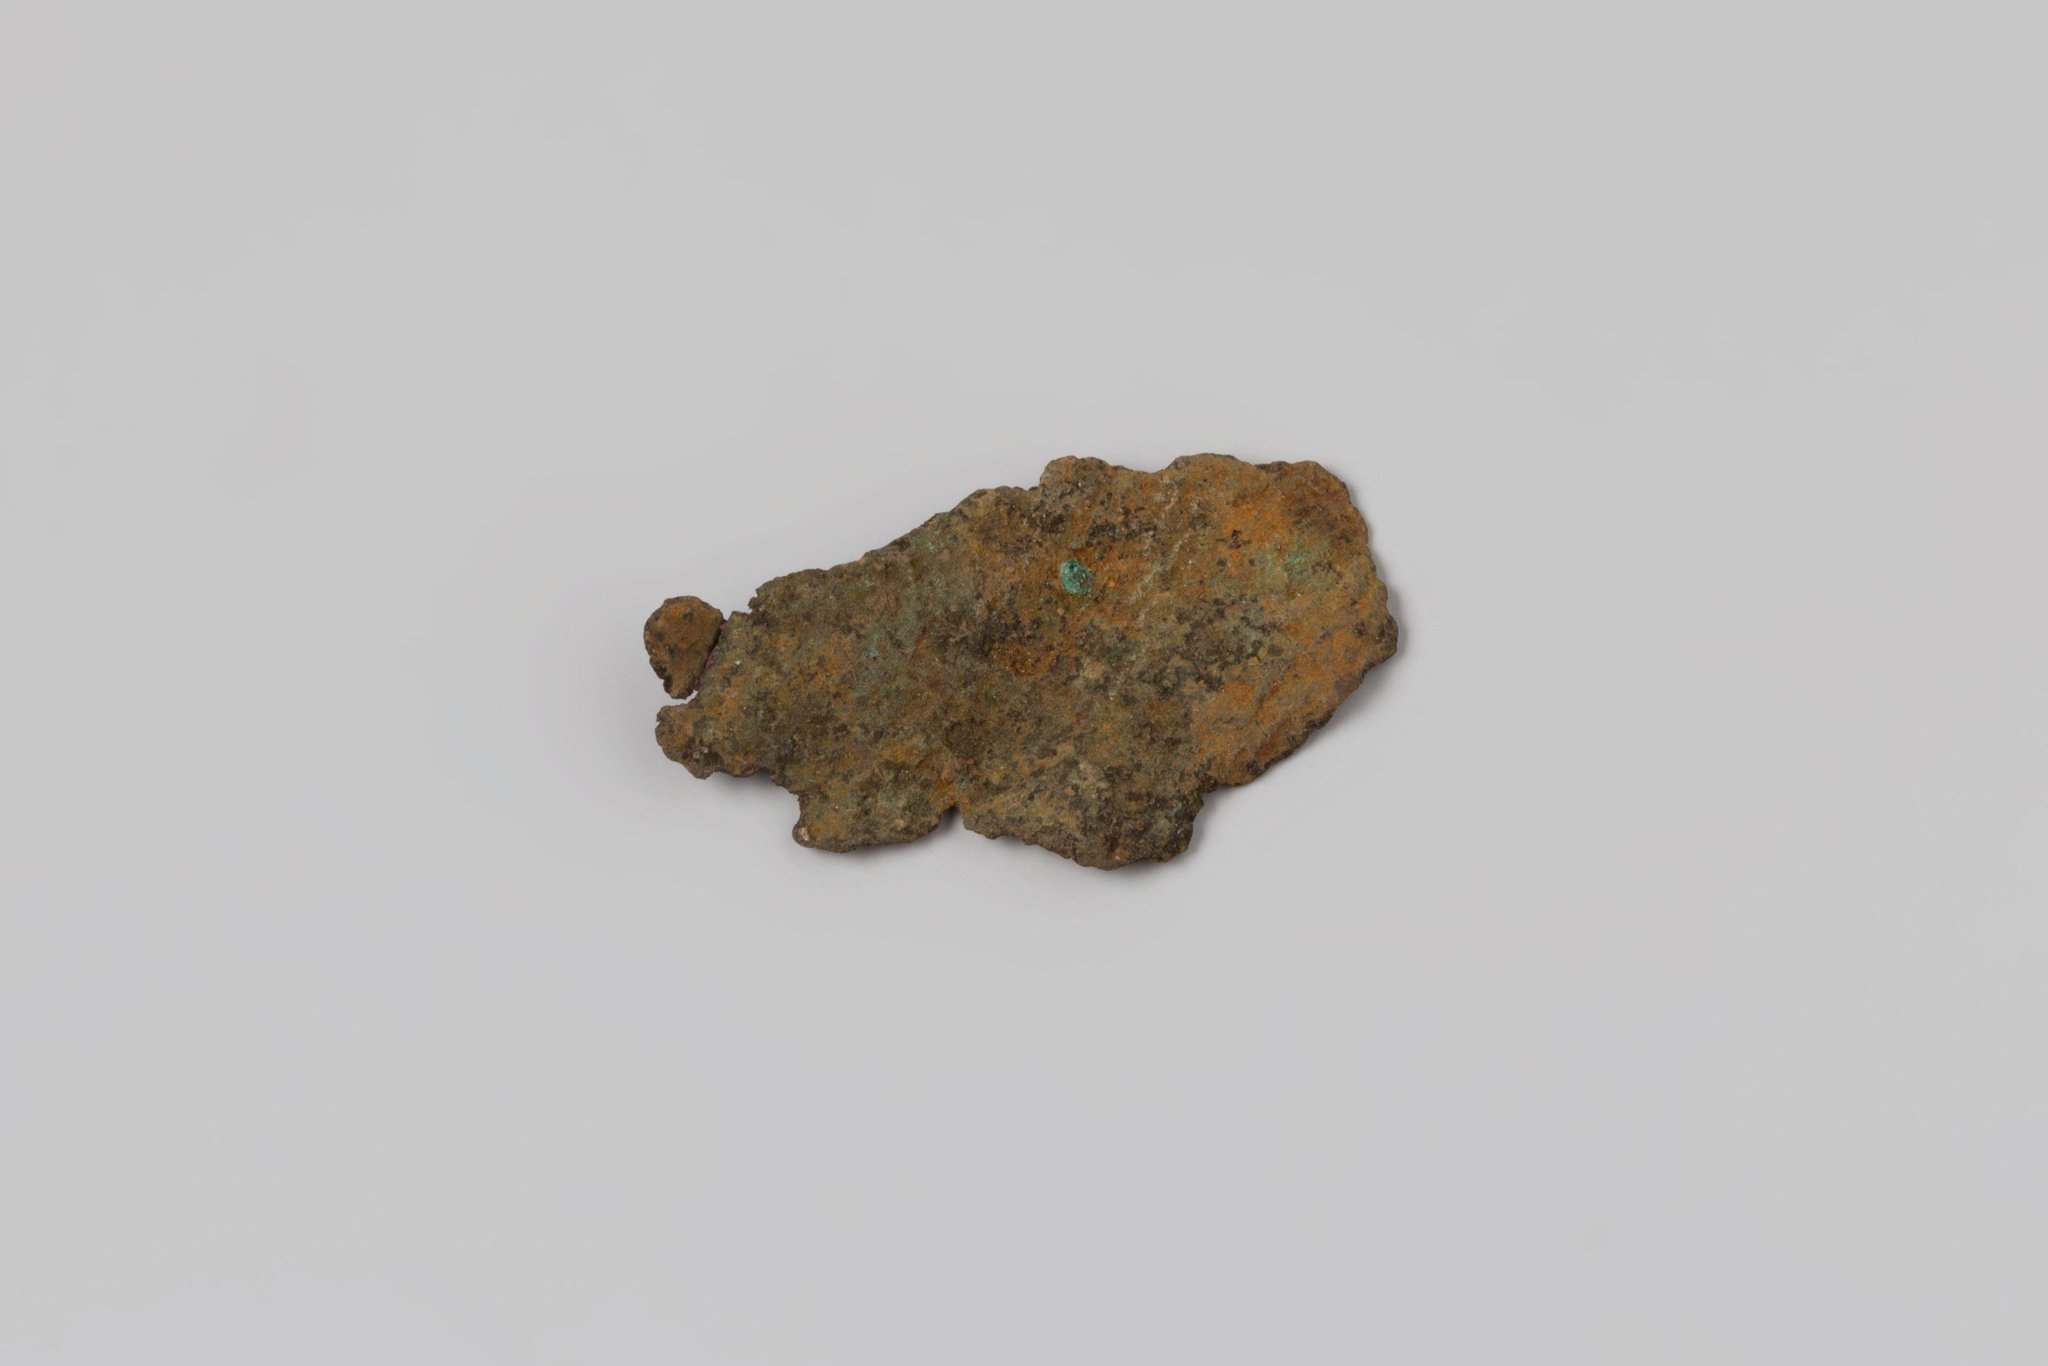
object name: scheepswrakvondst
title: Fragment van koper uit het wrak van de Oost-Indiëvaarder Hollandia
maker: Anonymous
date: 1700-1743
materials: copper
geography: netherlands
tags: verenigde oostindische compagnie, hollandia (schip), annet